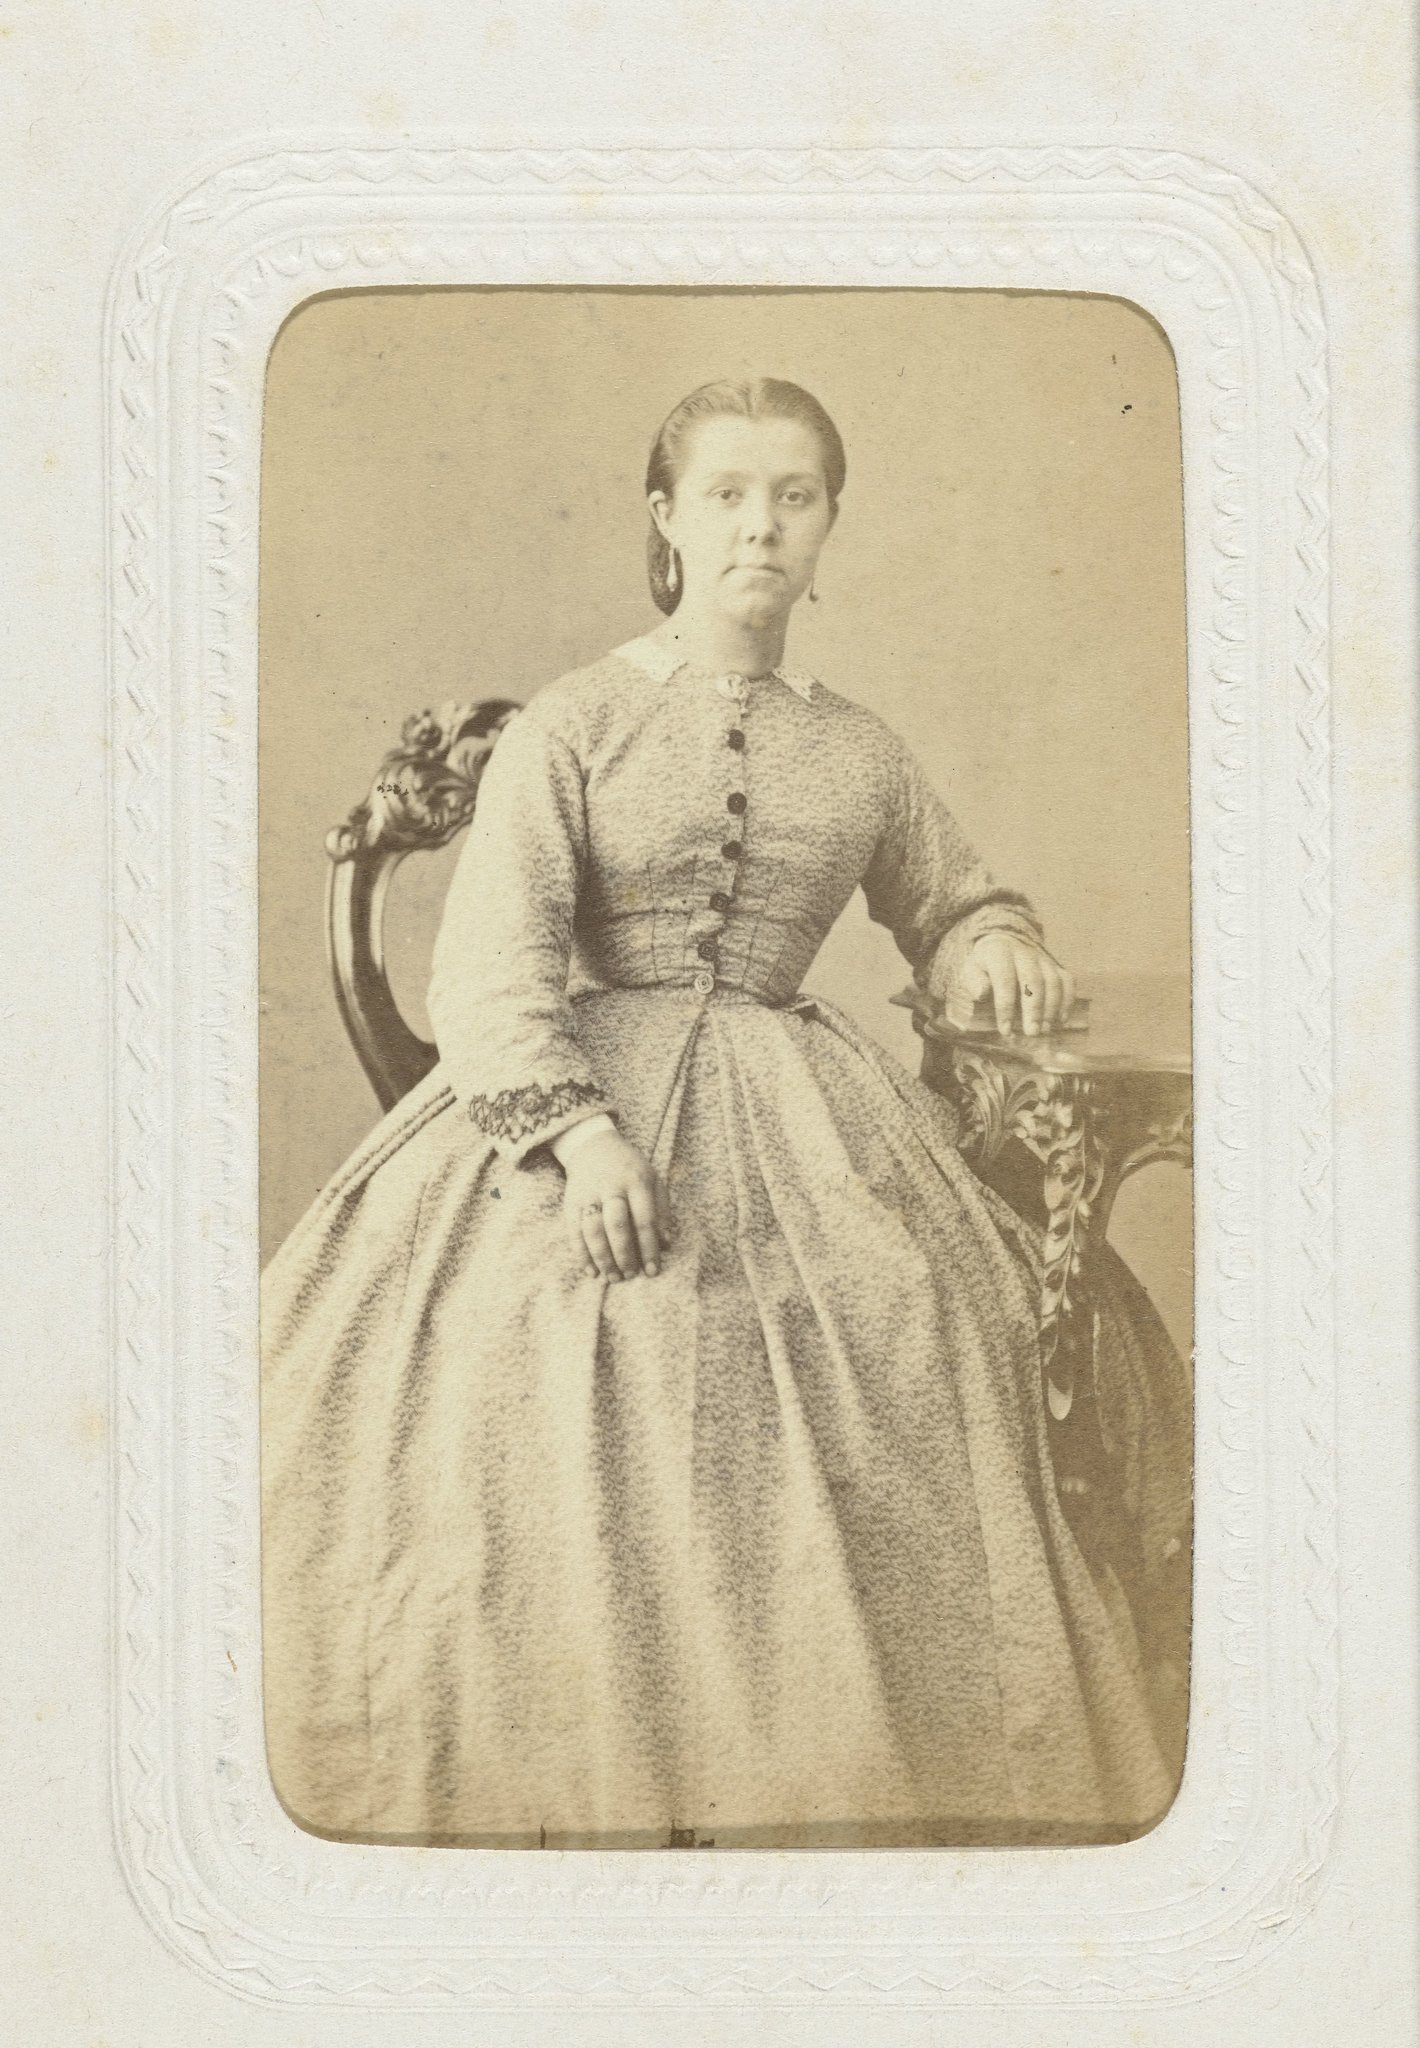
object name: carte de visite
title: Studioportret van een vrouw aan tafel in een lange, bolle jurk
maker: willem gerhardus kuijer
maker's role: fotograaf, hoffotograaf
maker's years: 1834-1899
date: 1863-1866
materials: cardboard, paper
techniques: albumen print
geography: amsterdam